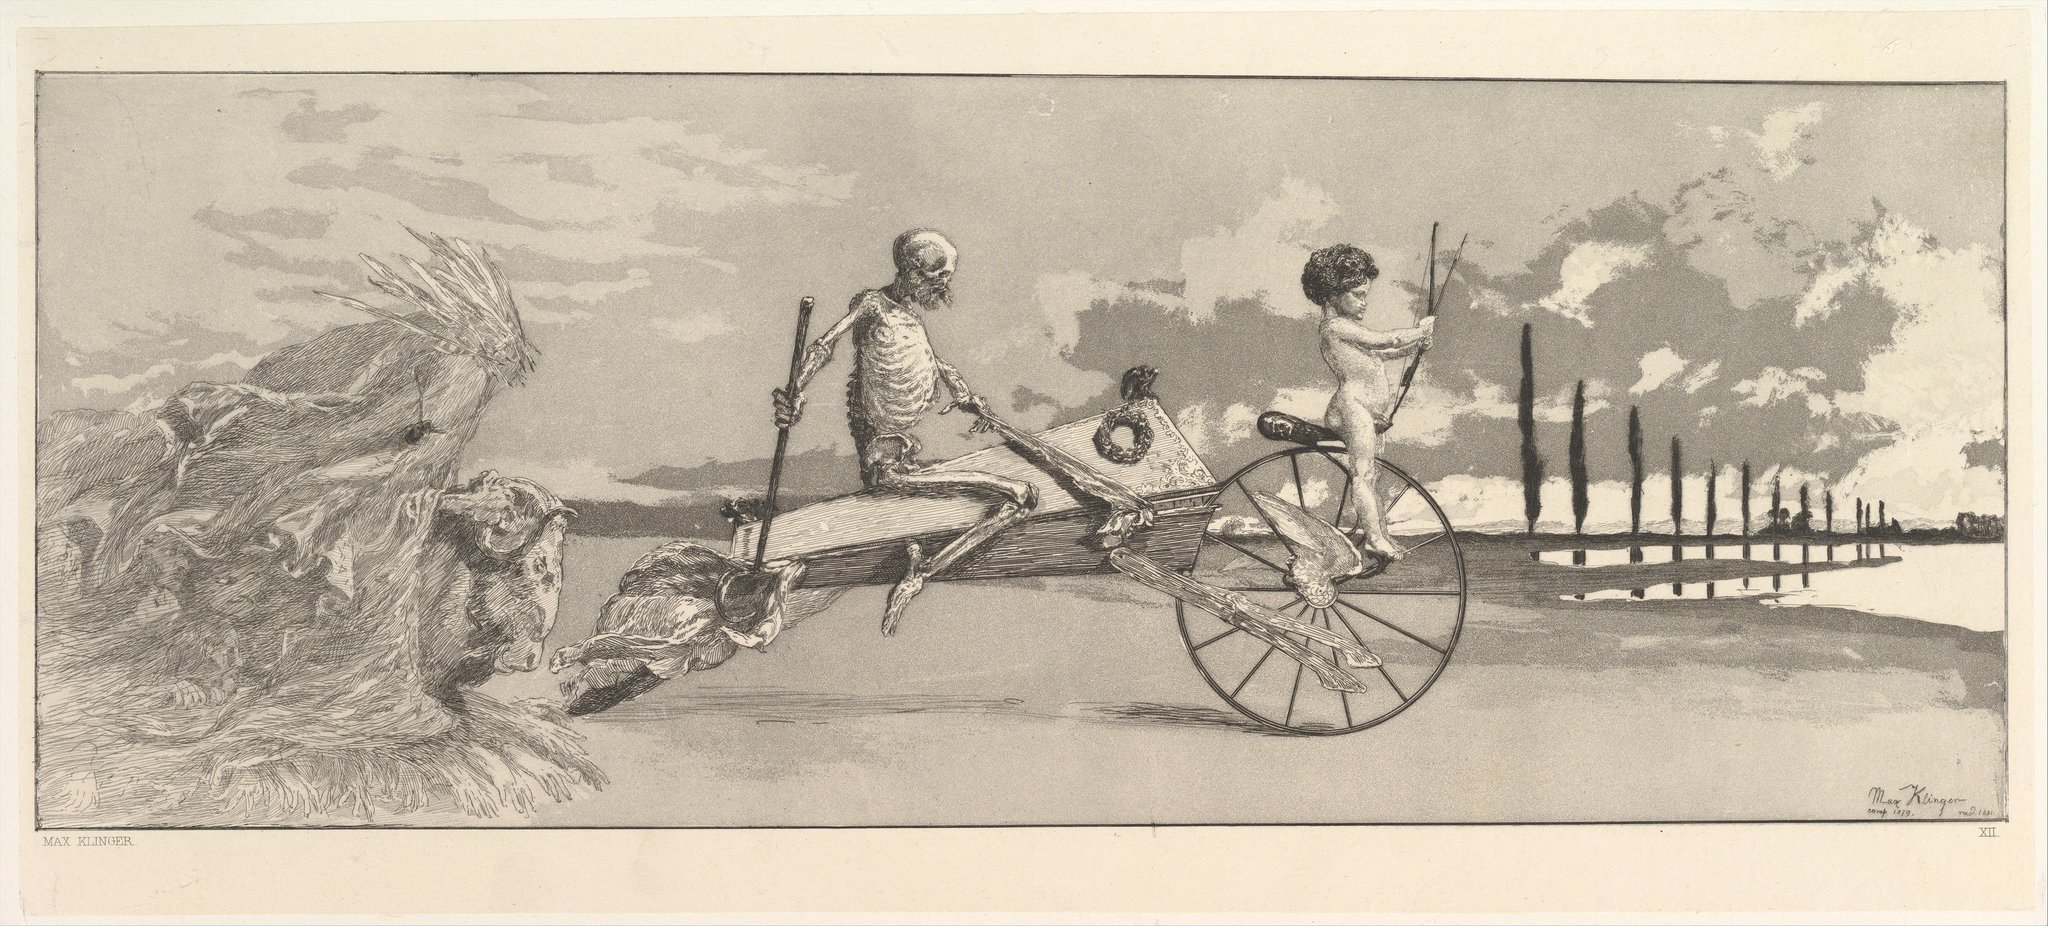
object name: print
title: Amor, Tod und Jenseits, from the series Intermezzi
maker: max klinger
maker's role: artist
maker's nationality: german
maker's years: 1857-1920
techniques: aquatint, printmaking, etching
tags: weapons,skeletons,cupid